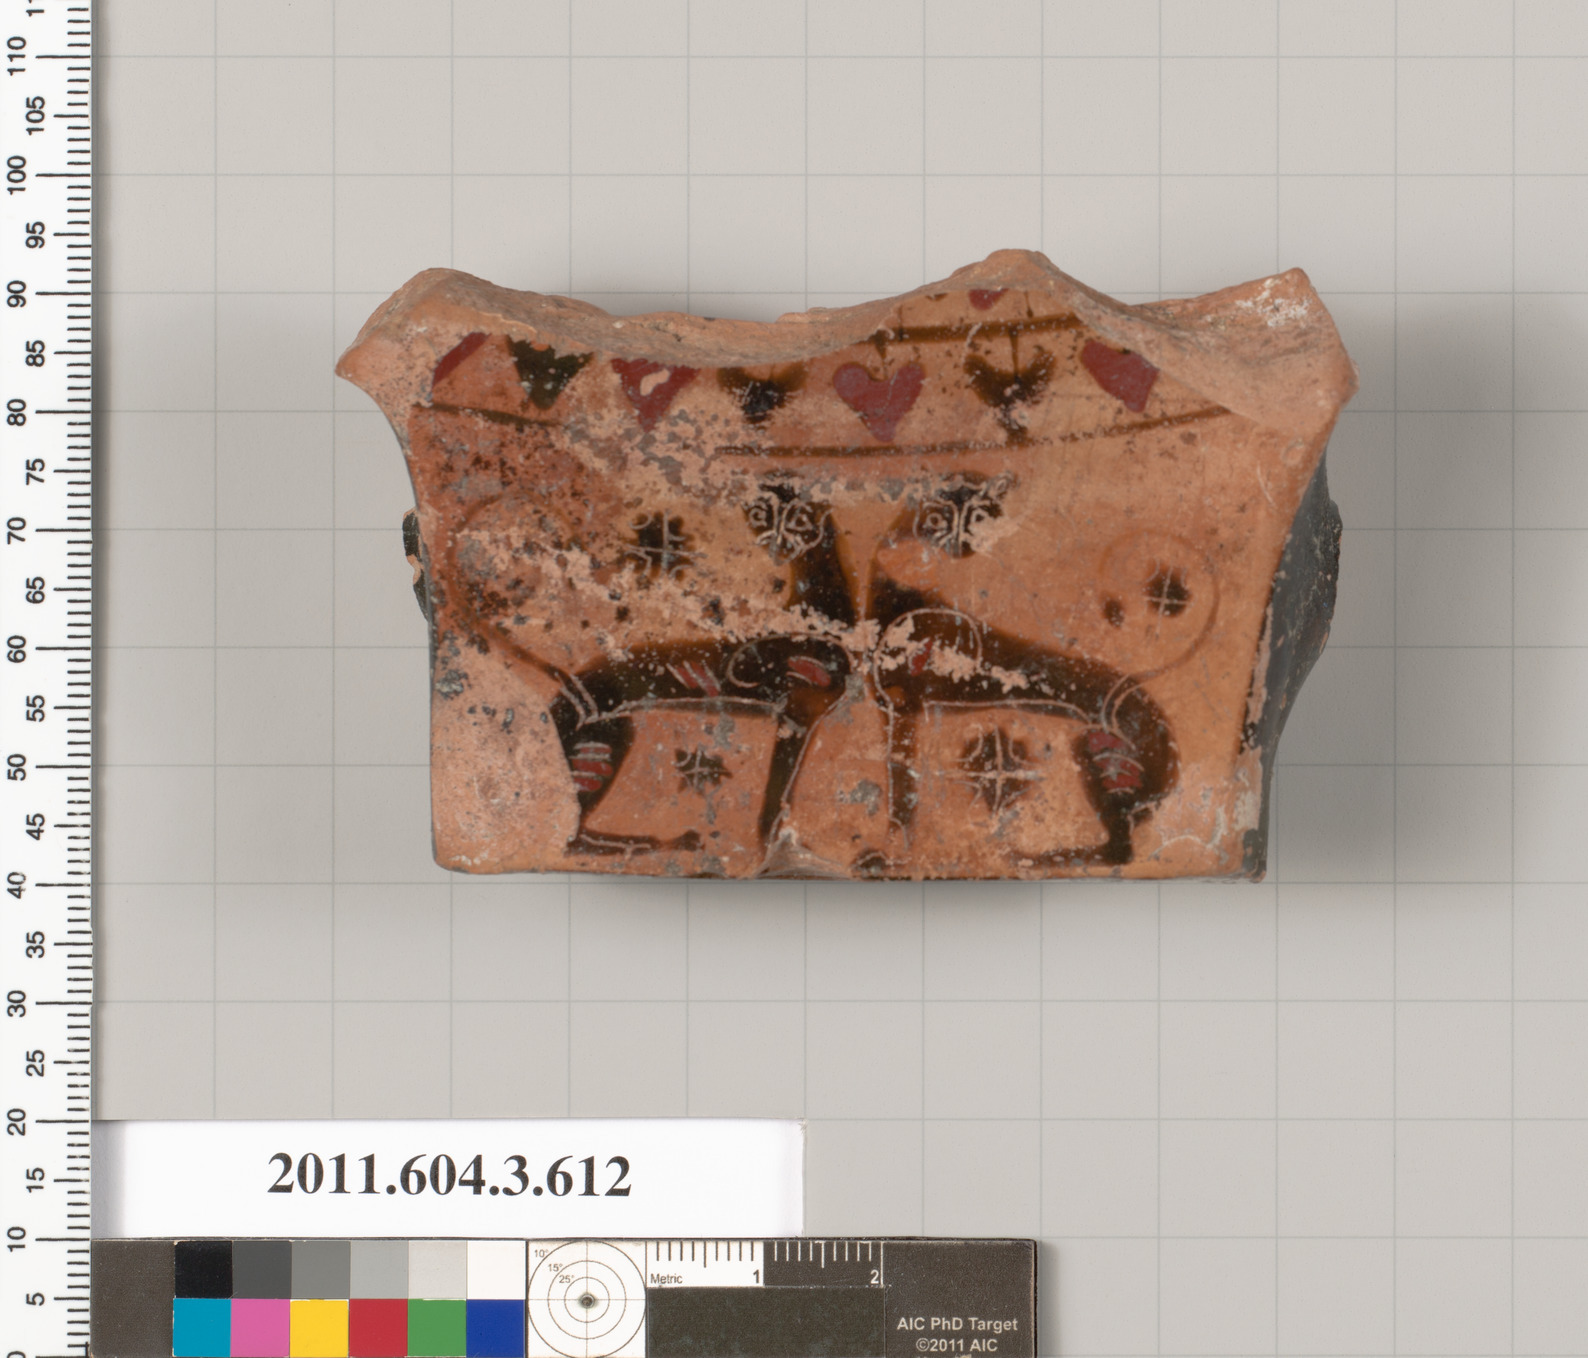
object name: column krater fragment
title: Terracotta fragment of a column-krater (bowl for mixing wine and water)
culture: greek, attic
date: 567-535 BCE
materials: terracotta